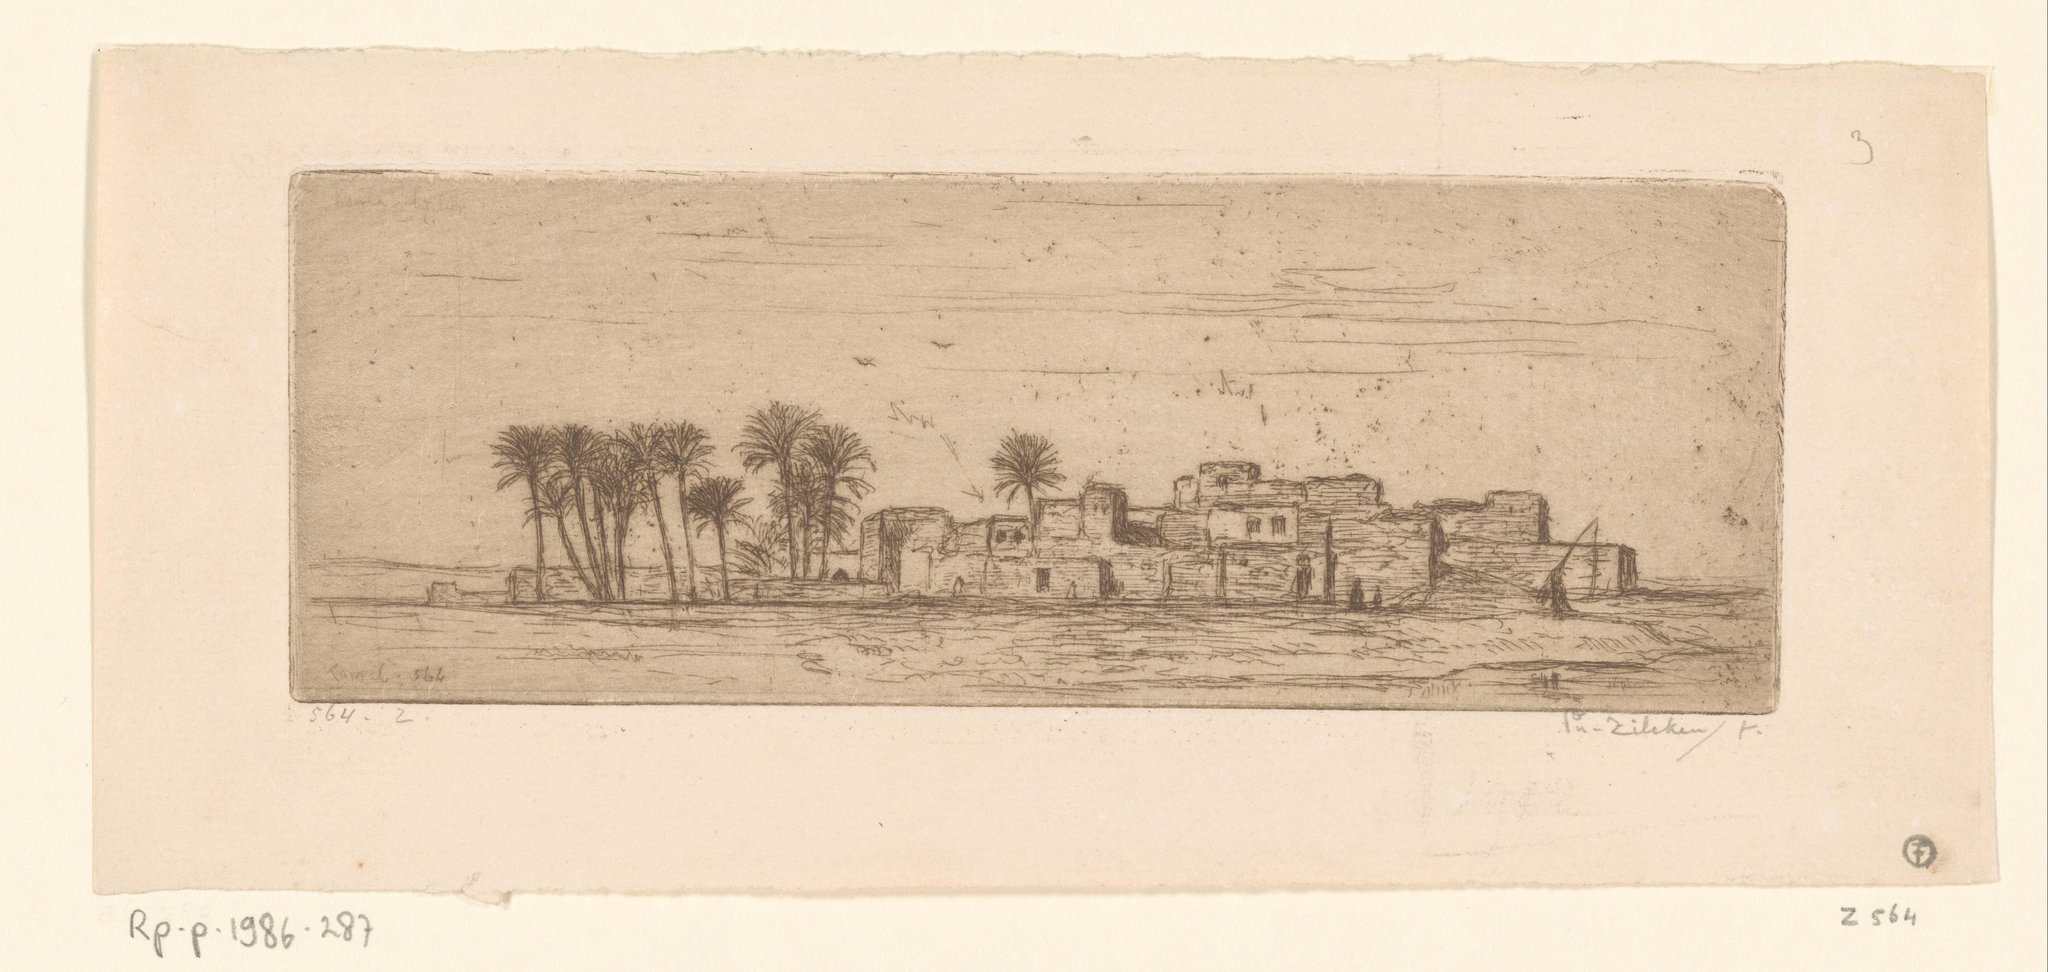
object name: print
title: Vue de Côm Al-Akhdar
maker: philip zilcken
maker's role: draughtsman, painter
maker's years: 1857-1930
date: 1890-1930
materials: paper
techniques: drypoint, etching, intaglio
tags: prospect of village, silhouette of village, desert, trees: palm-tree